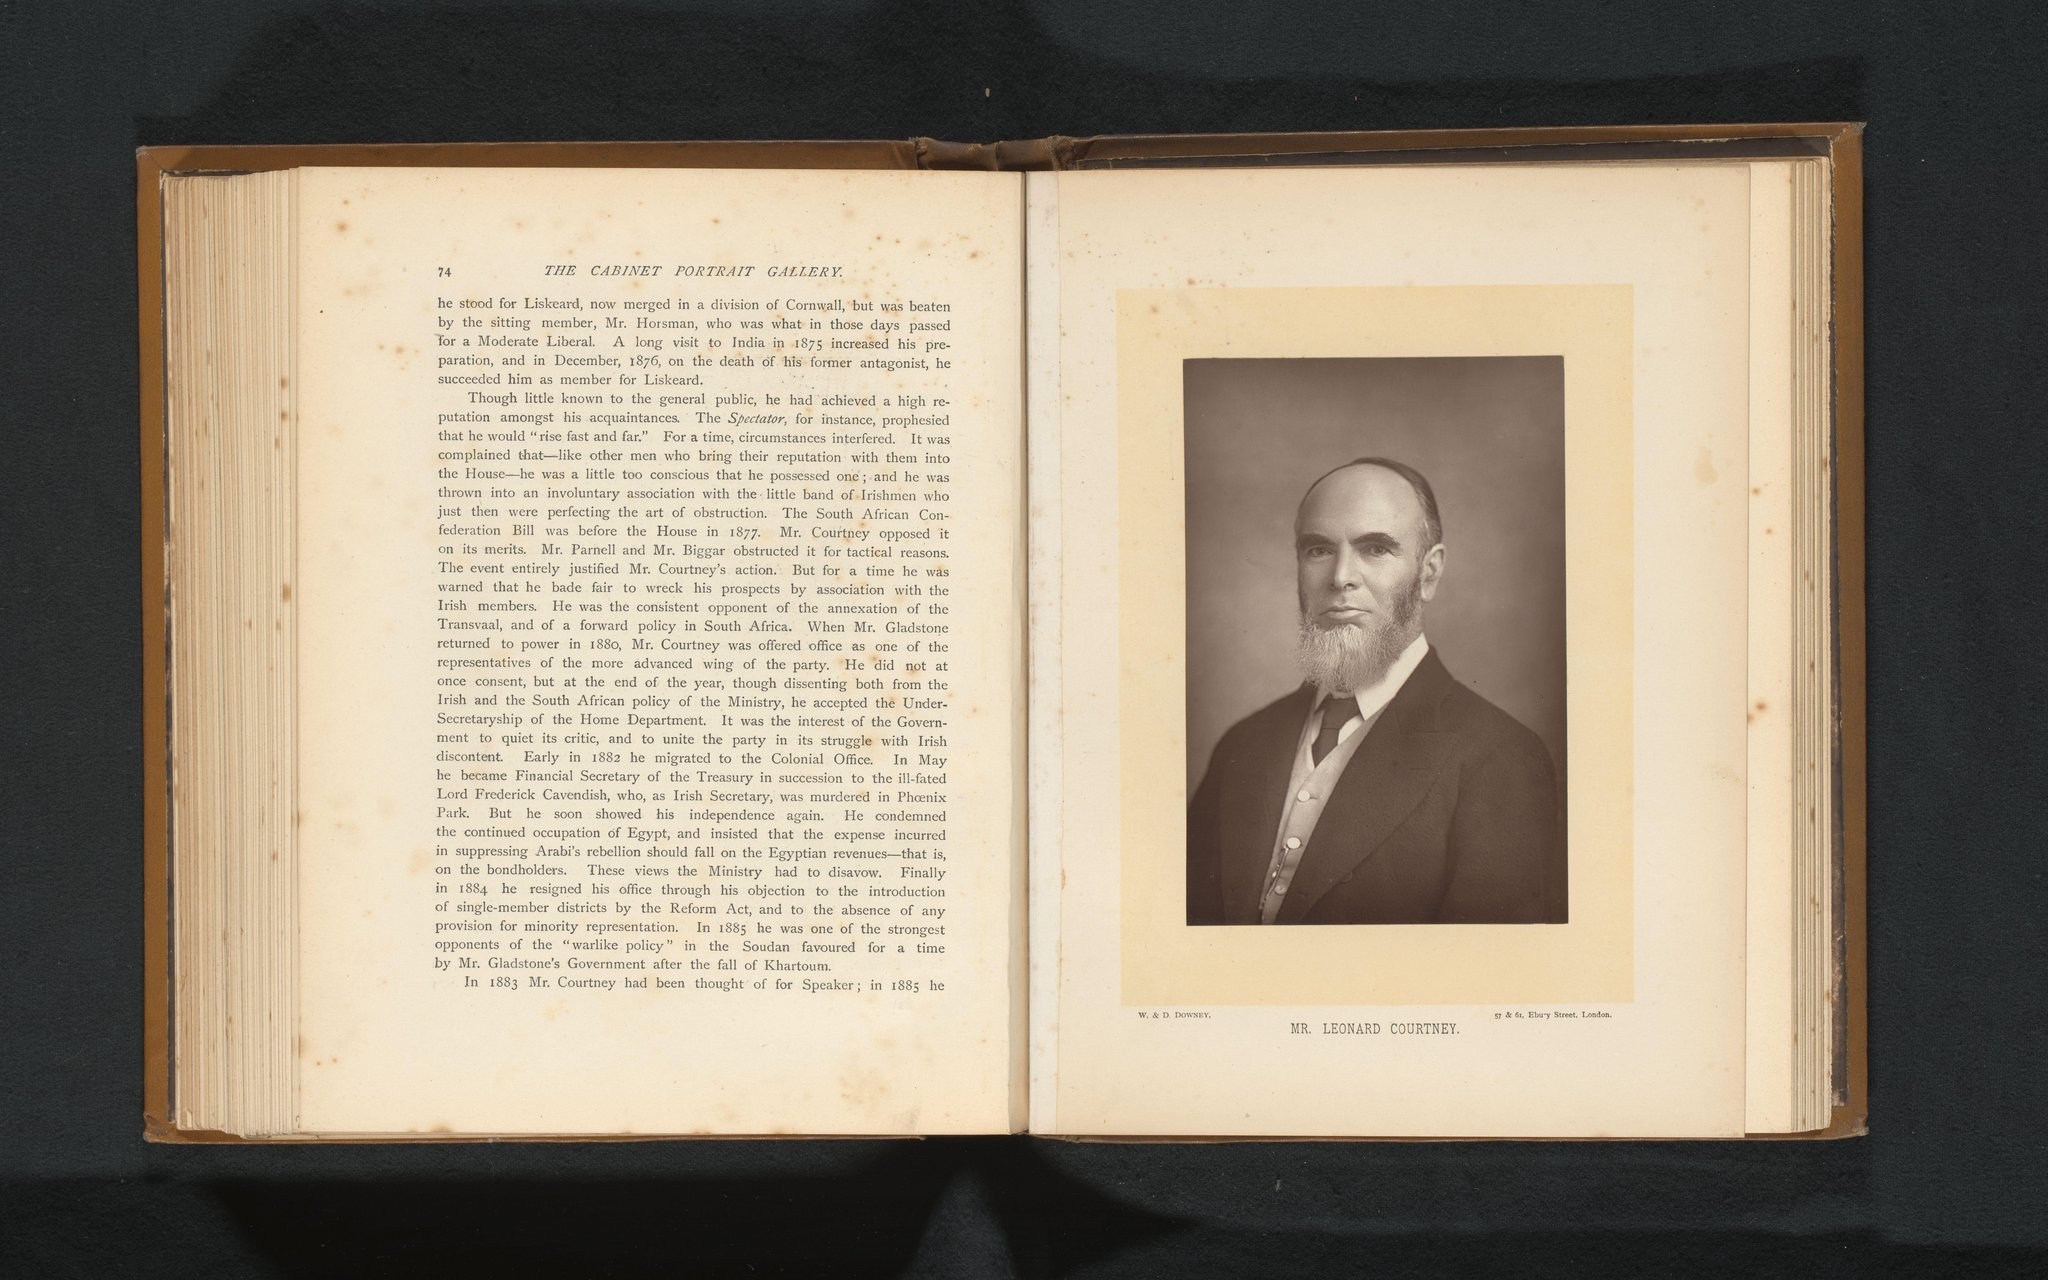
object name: photomechanical print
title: Mr. Leonard Courtney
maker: Anonymous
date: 1882-1892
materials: paper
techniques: woodburytype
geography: london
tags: politician, e.g. party leader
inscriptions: inscription: ‘57 & 61, Elbury Street, London.’